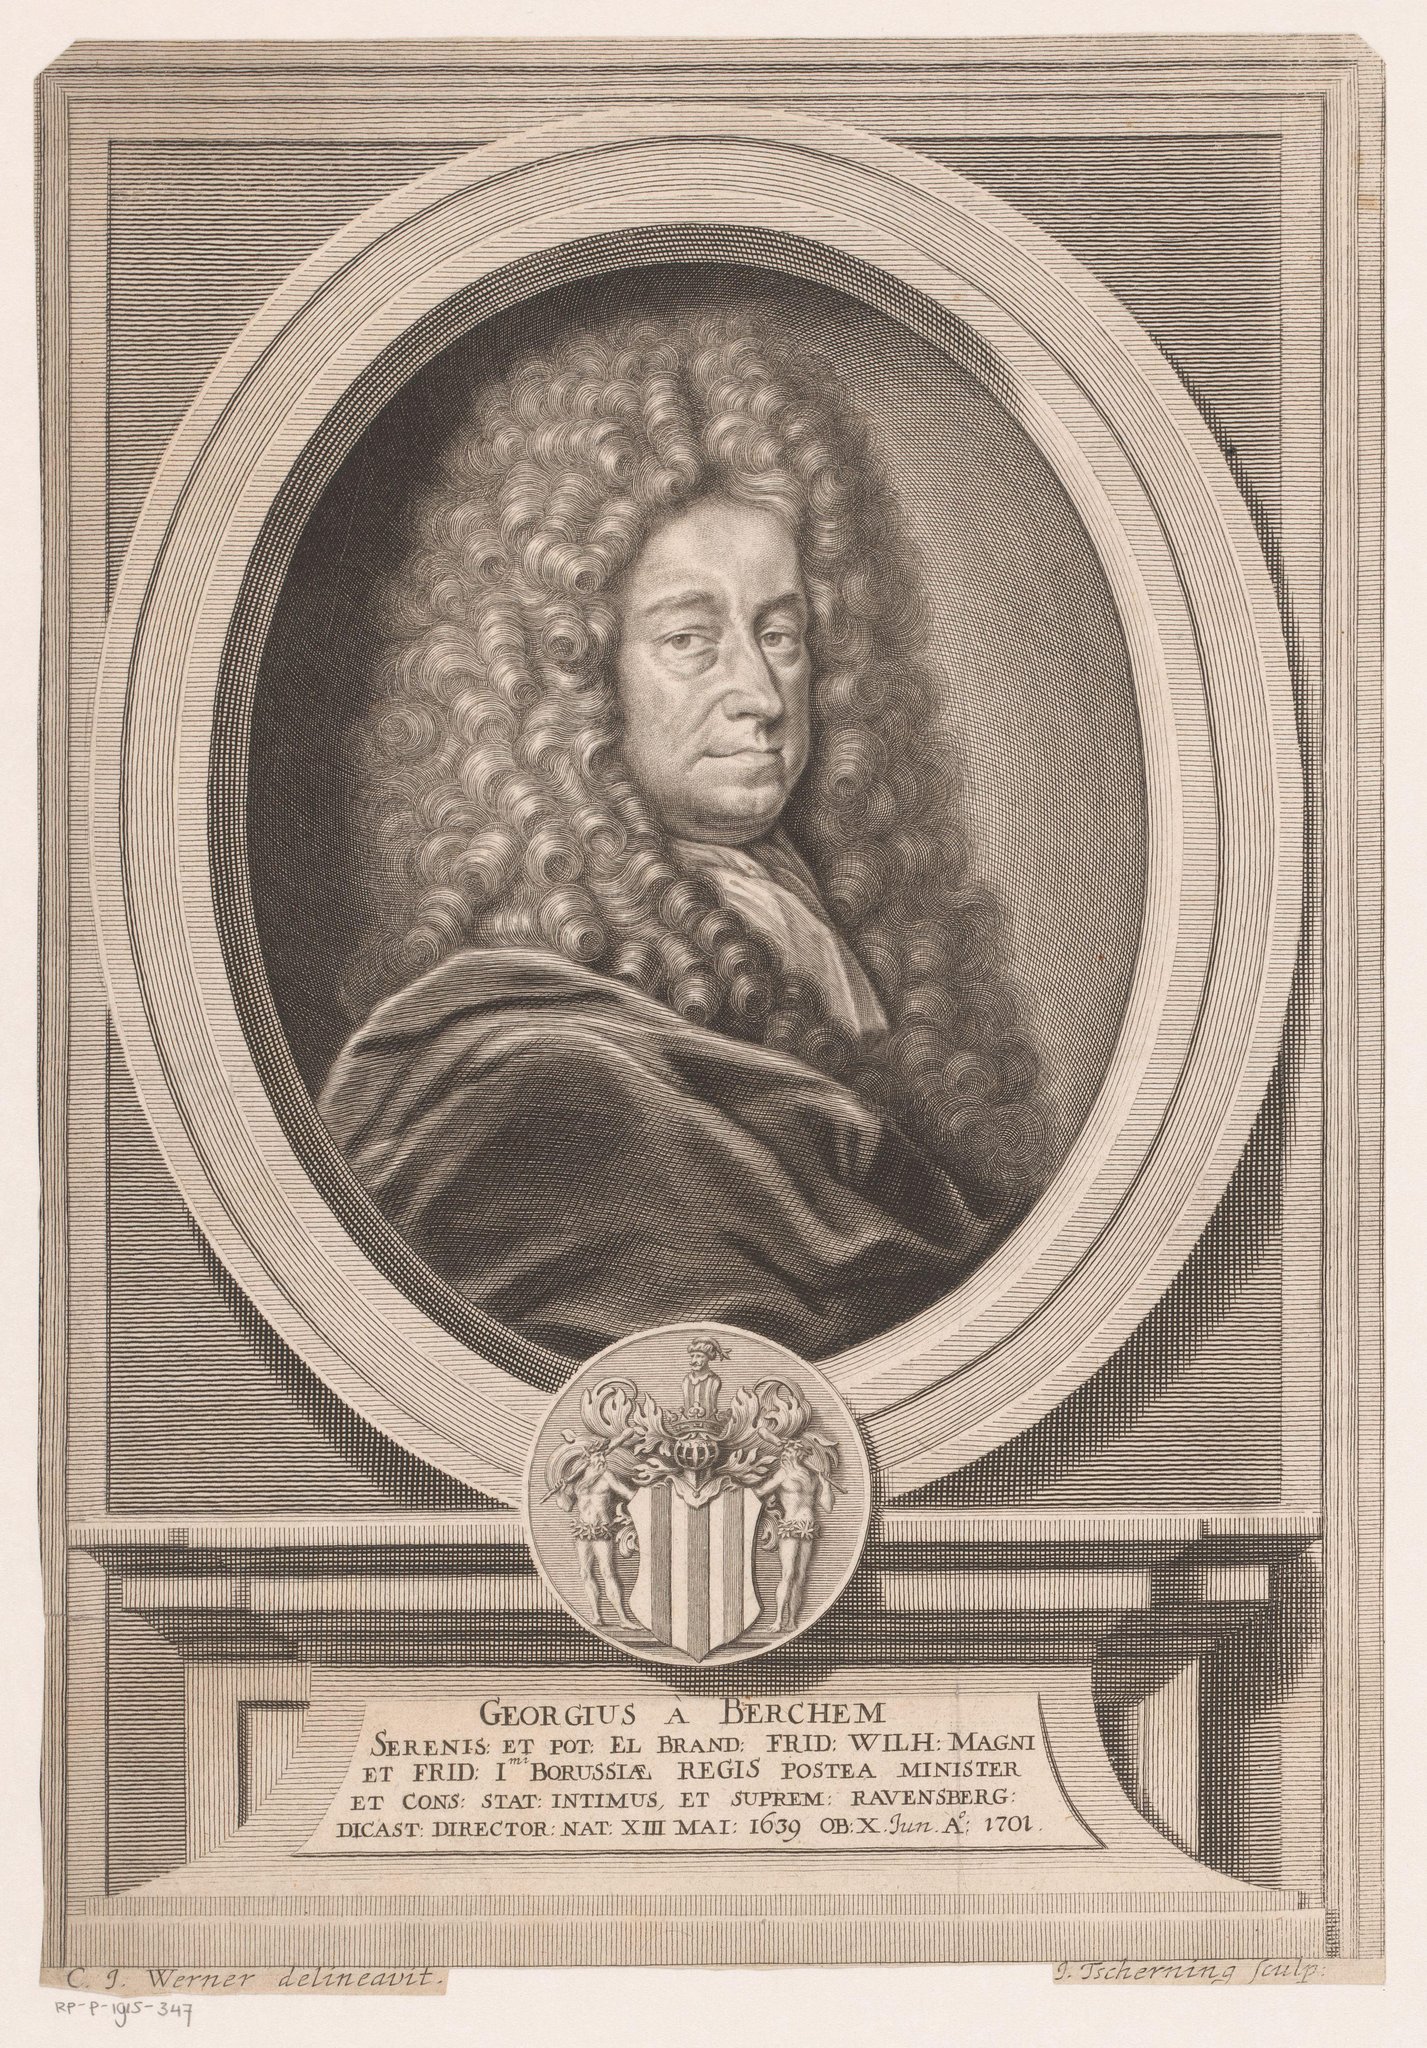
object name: print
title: Portret van Georg von Berchem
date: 1701-1729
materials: paper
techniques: engraving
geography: germany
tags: berlin, historical persons, armorial bearing, heraldry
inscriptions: collector's mark: Lugt 2228